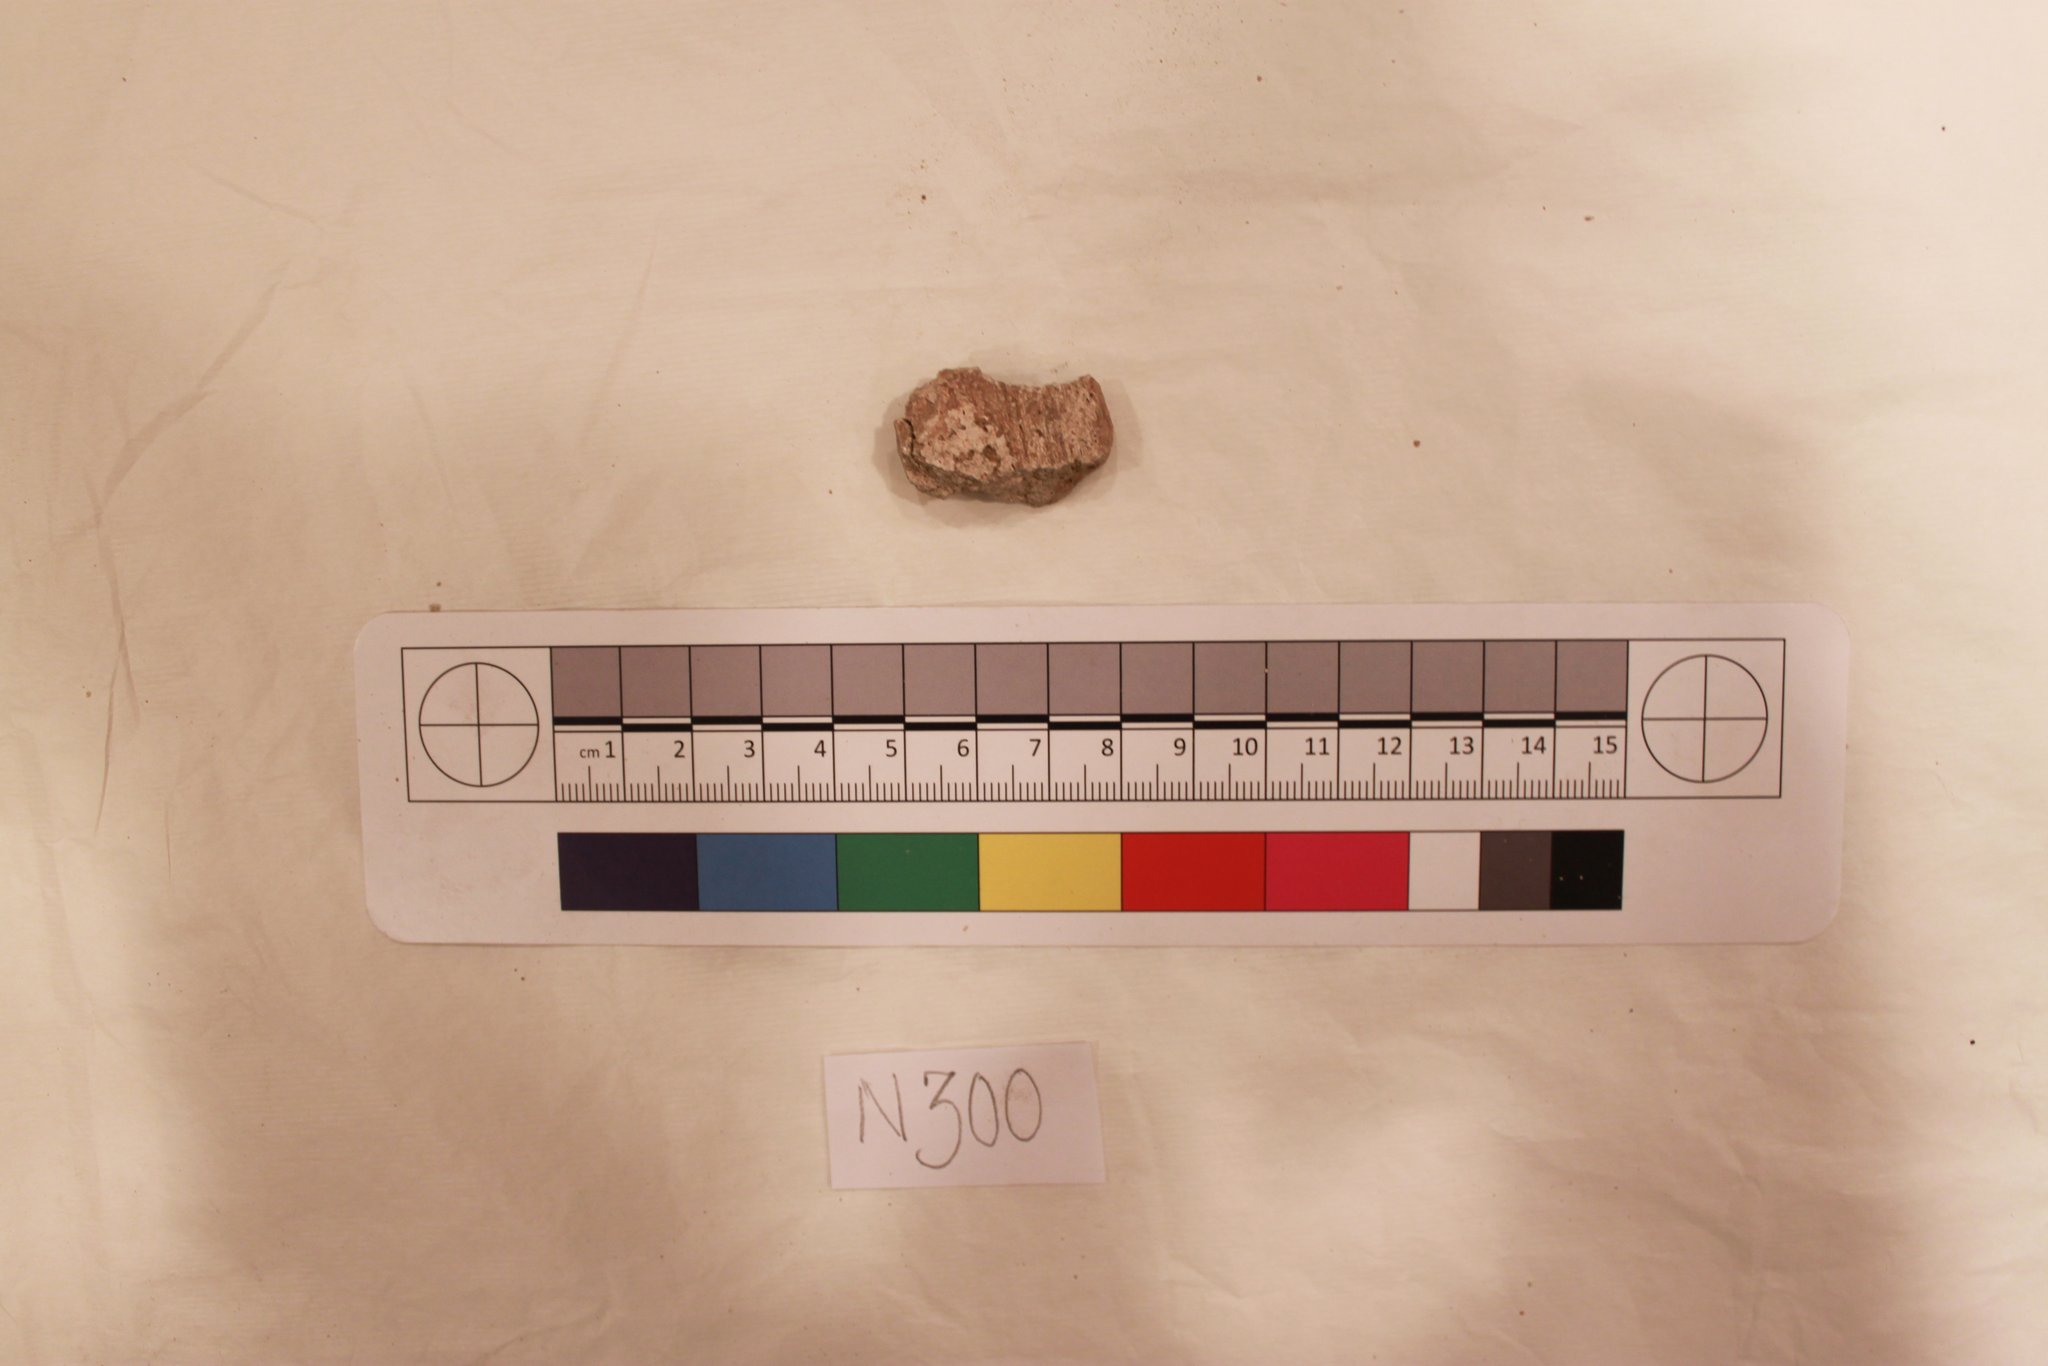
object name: fragment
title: Stucco Fragment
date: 701-1200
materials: plaster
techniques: carving, painting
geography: iran